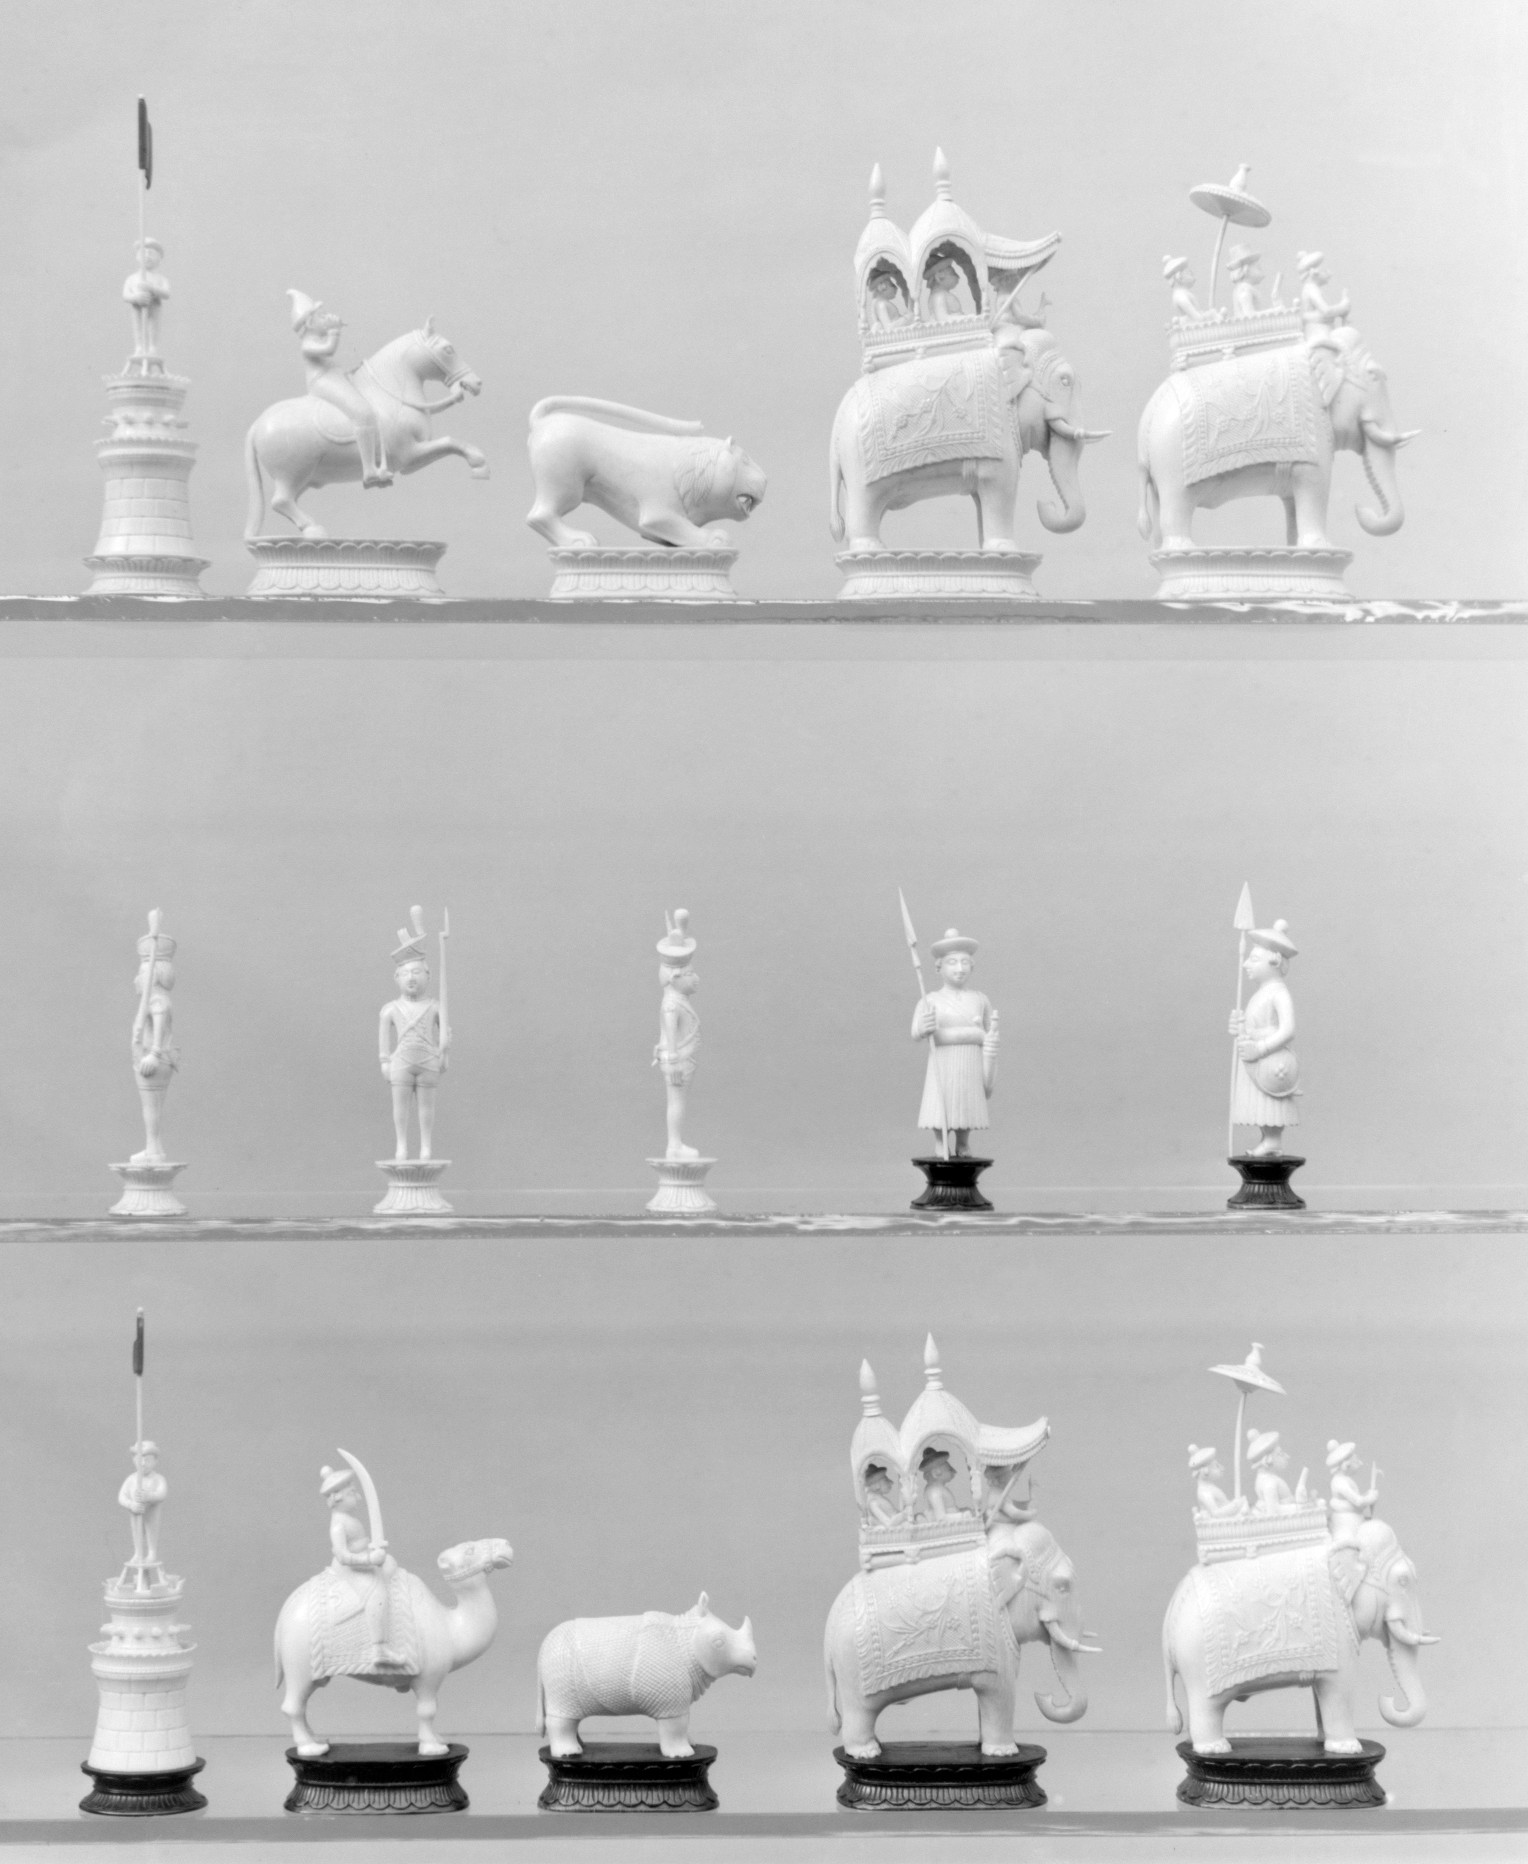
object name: chessman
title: Chessmen (32)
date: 1767-1800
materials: ivory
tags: chess,games